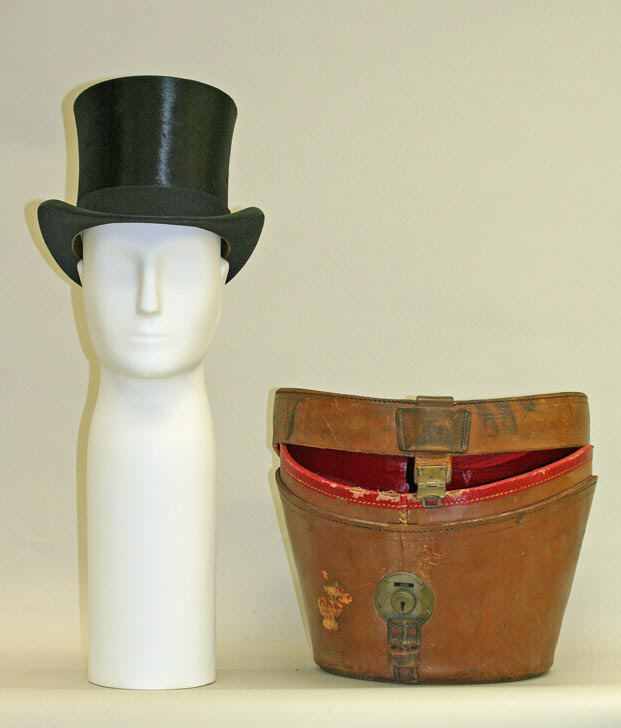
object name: hat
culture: american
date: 1870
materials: leather, silk